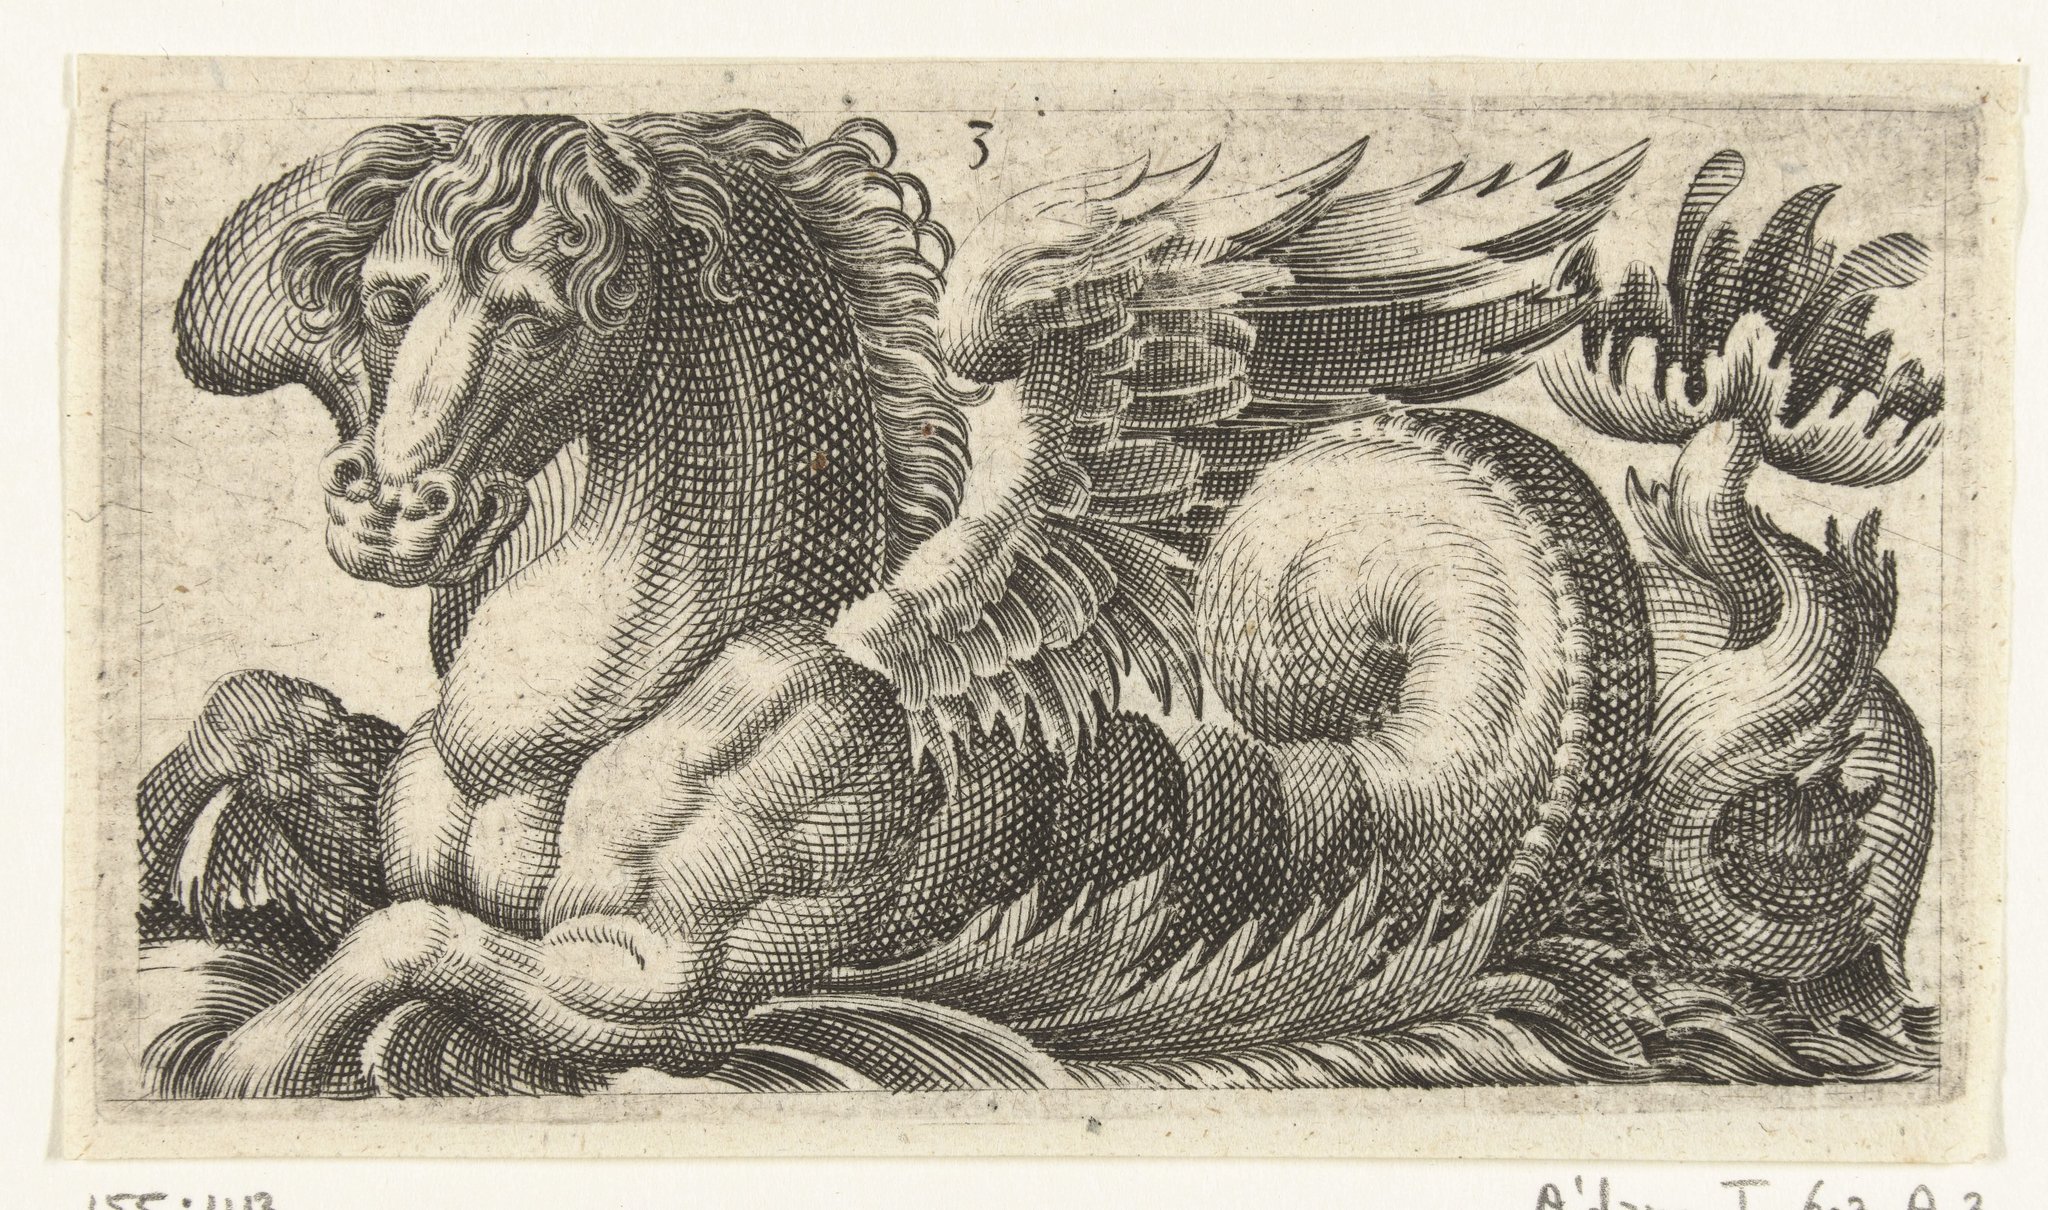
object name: print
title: Gevleugeld zeepaard met aan het einde van zijn staart een open blad waaruit twee stampers steken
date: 1526-1606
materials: paper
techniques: engraving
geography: germany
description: Tegenzijdige kopie naar prent met objectnummer RP-P-1984-436.